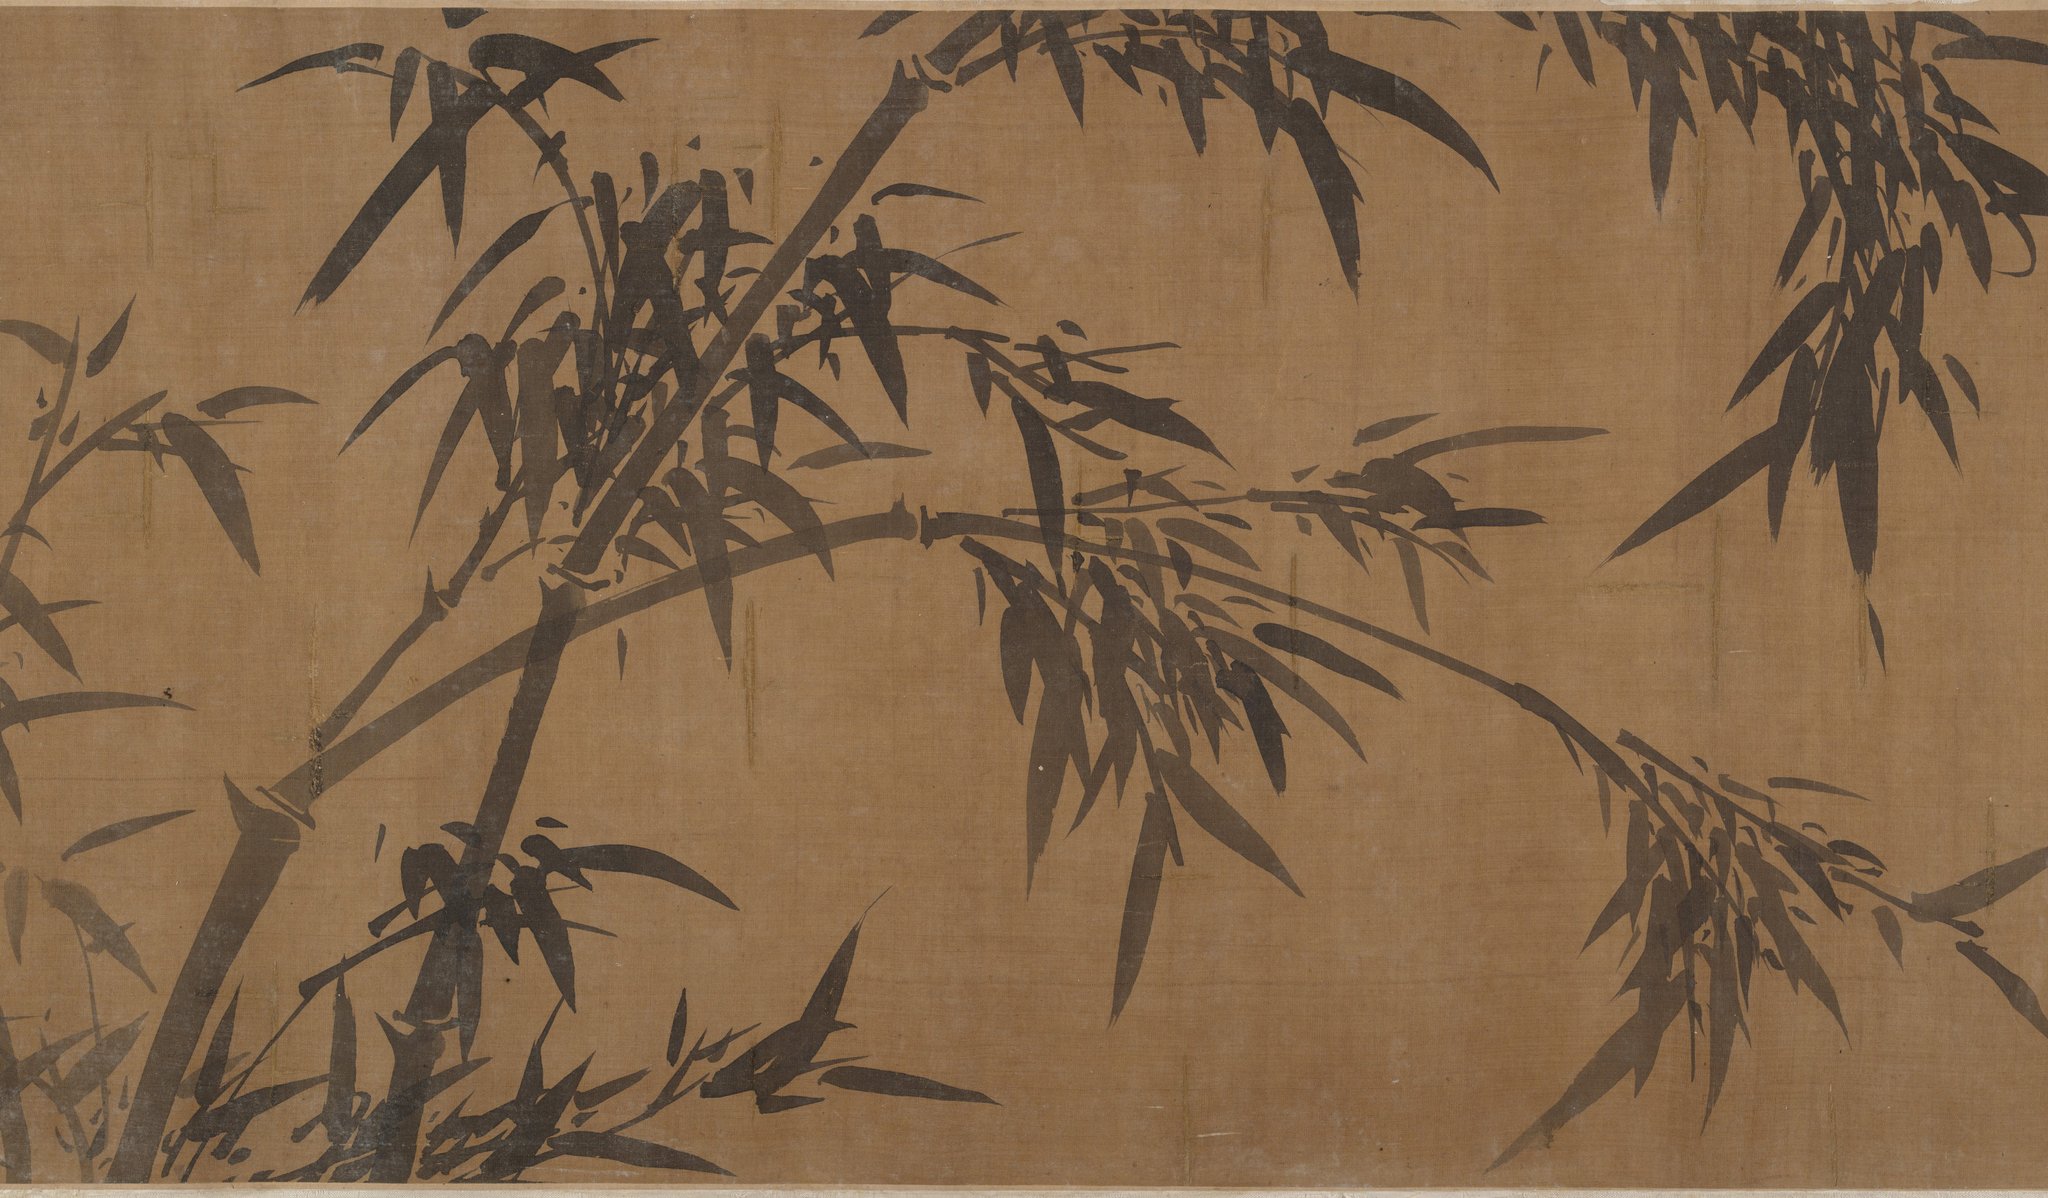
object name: handscroll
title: Bamboos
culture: chinese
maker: unidentified artist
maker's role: artist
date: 1368-1644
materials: ink, silk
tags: bamboo